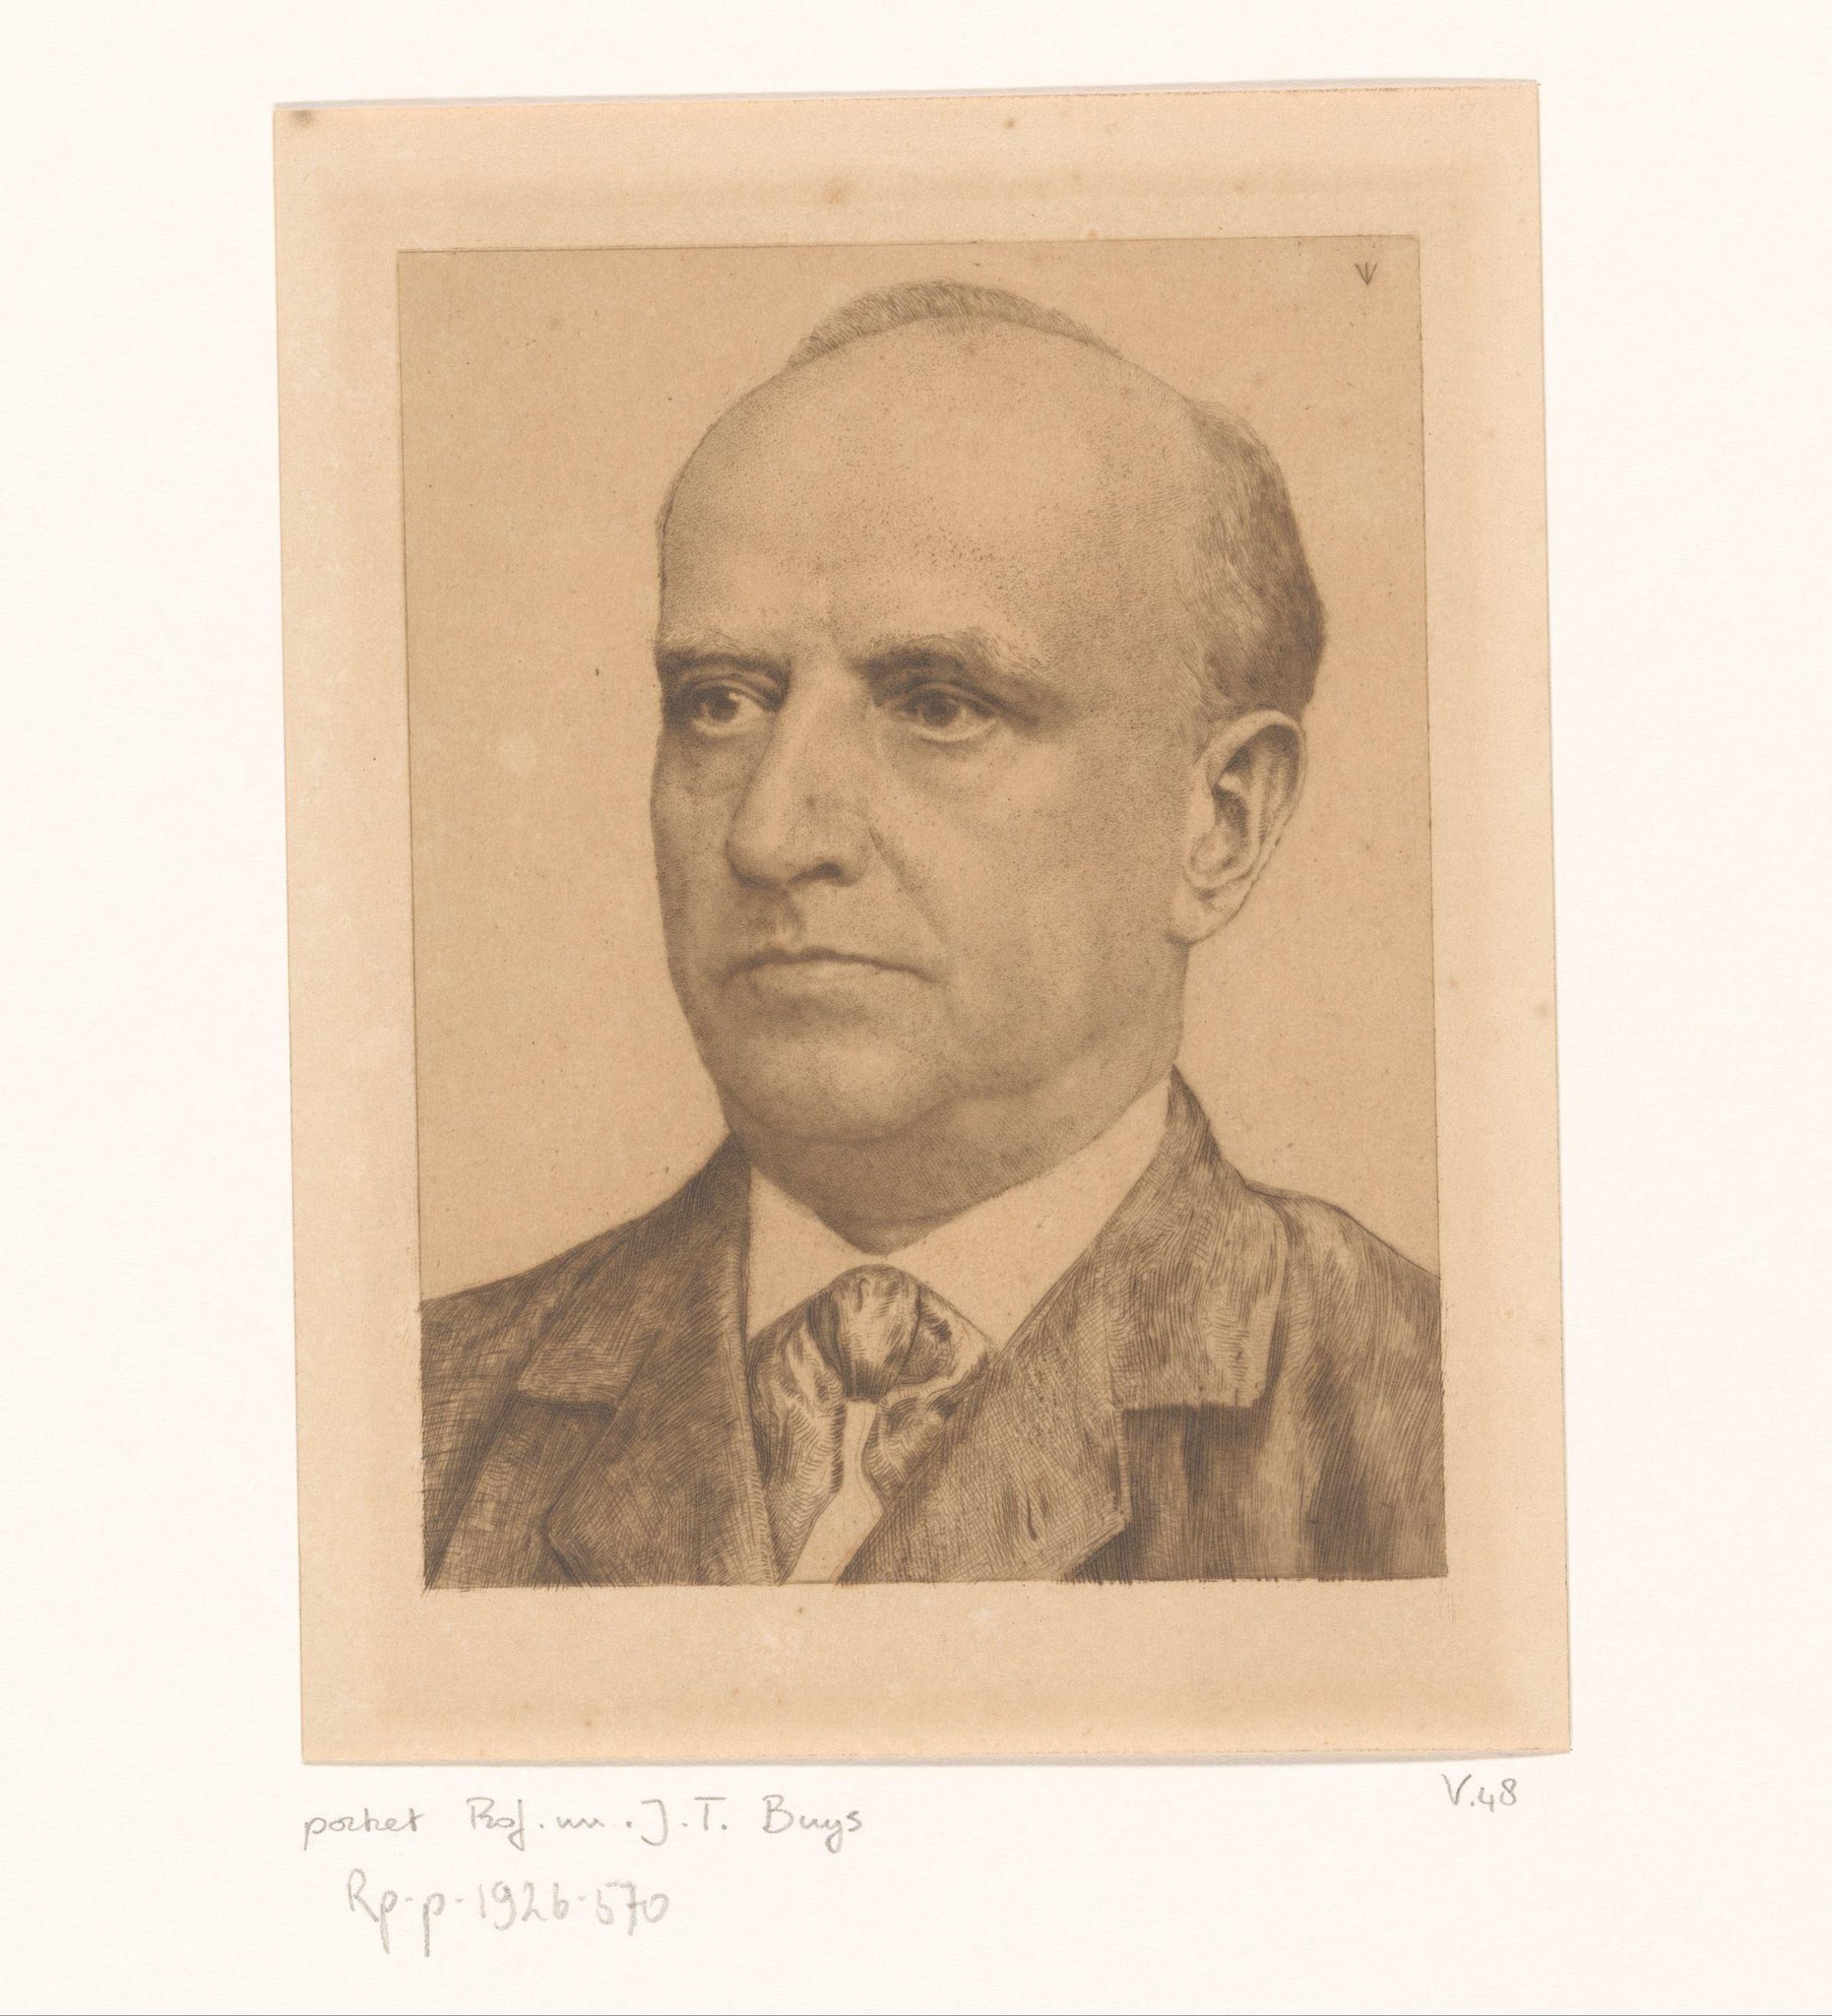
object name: print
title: Portret van Johannes Theodoor Buys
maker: jan veth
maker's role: designer, draughtsman, painter, print maker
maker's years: 1864-1925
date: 1893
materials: paper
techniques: etching, intaglio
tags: historical persons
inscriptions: collector's mark: Lugt 2228